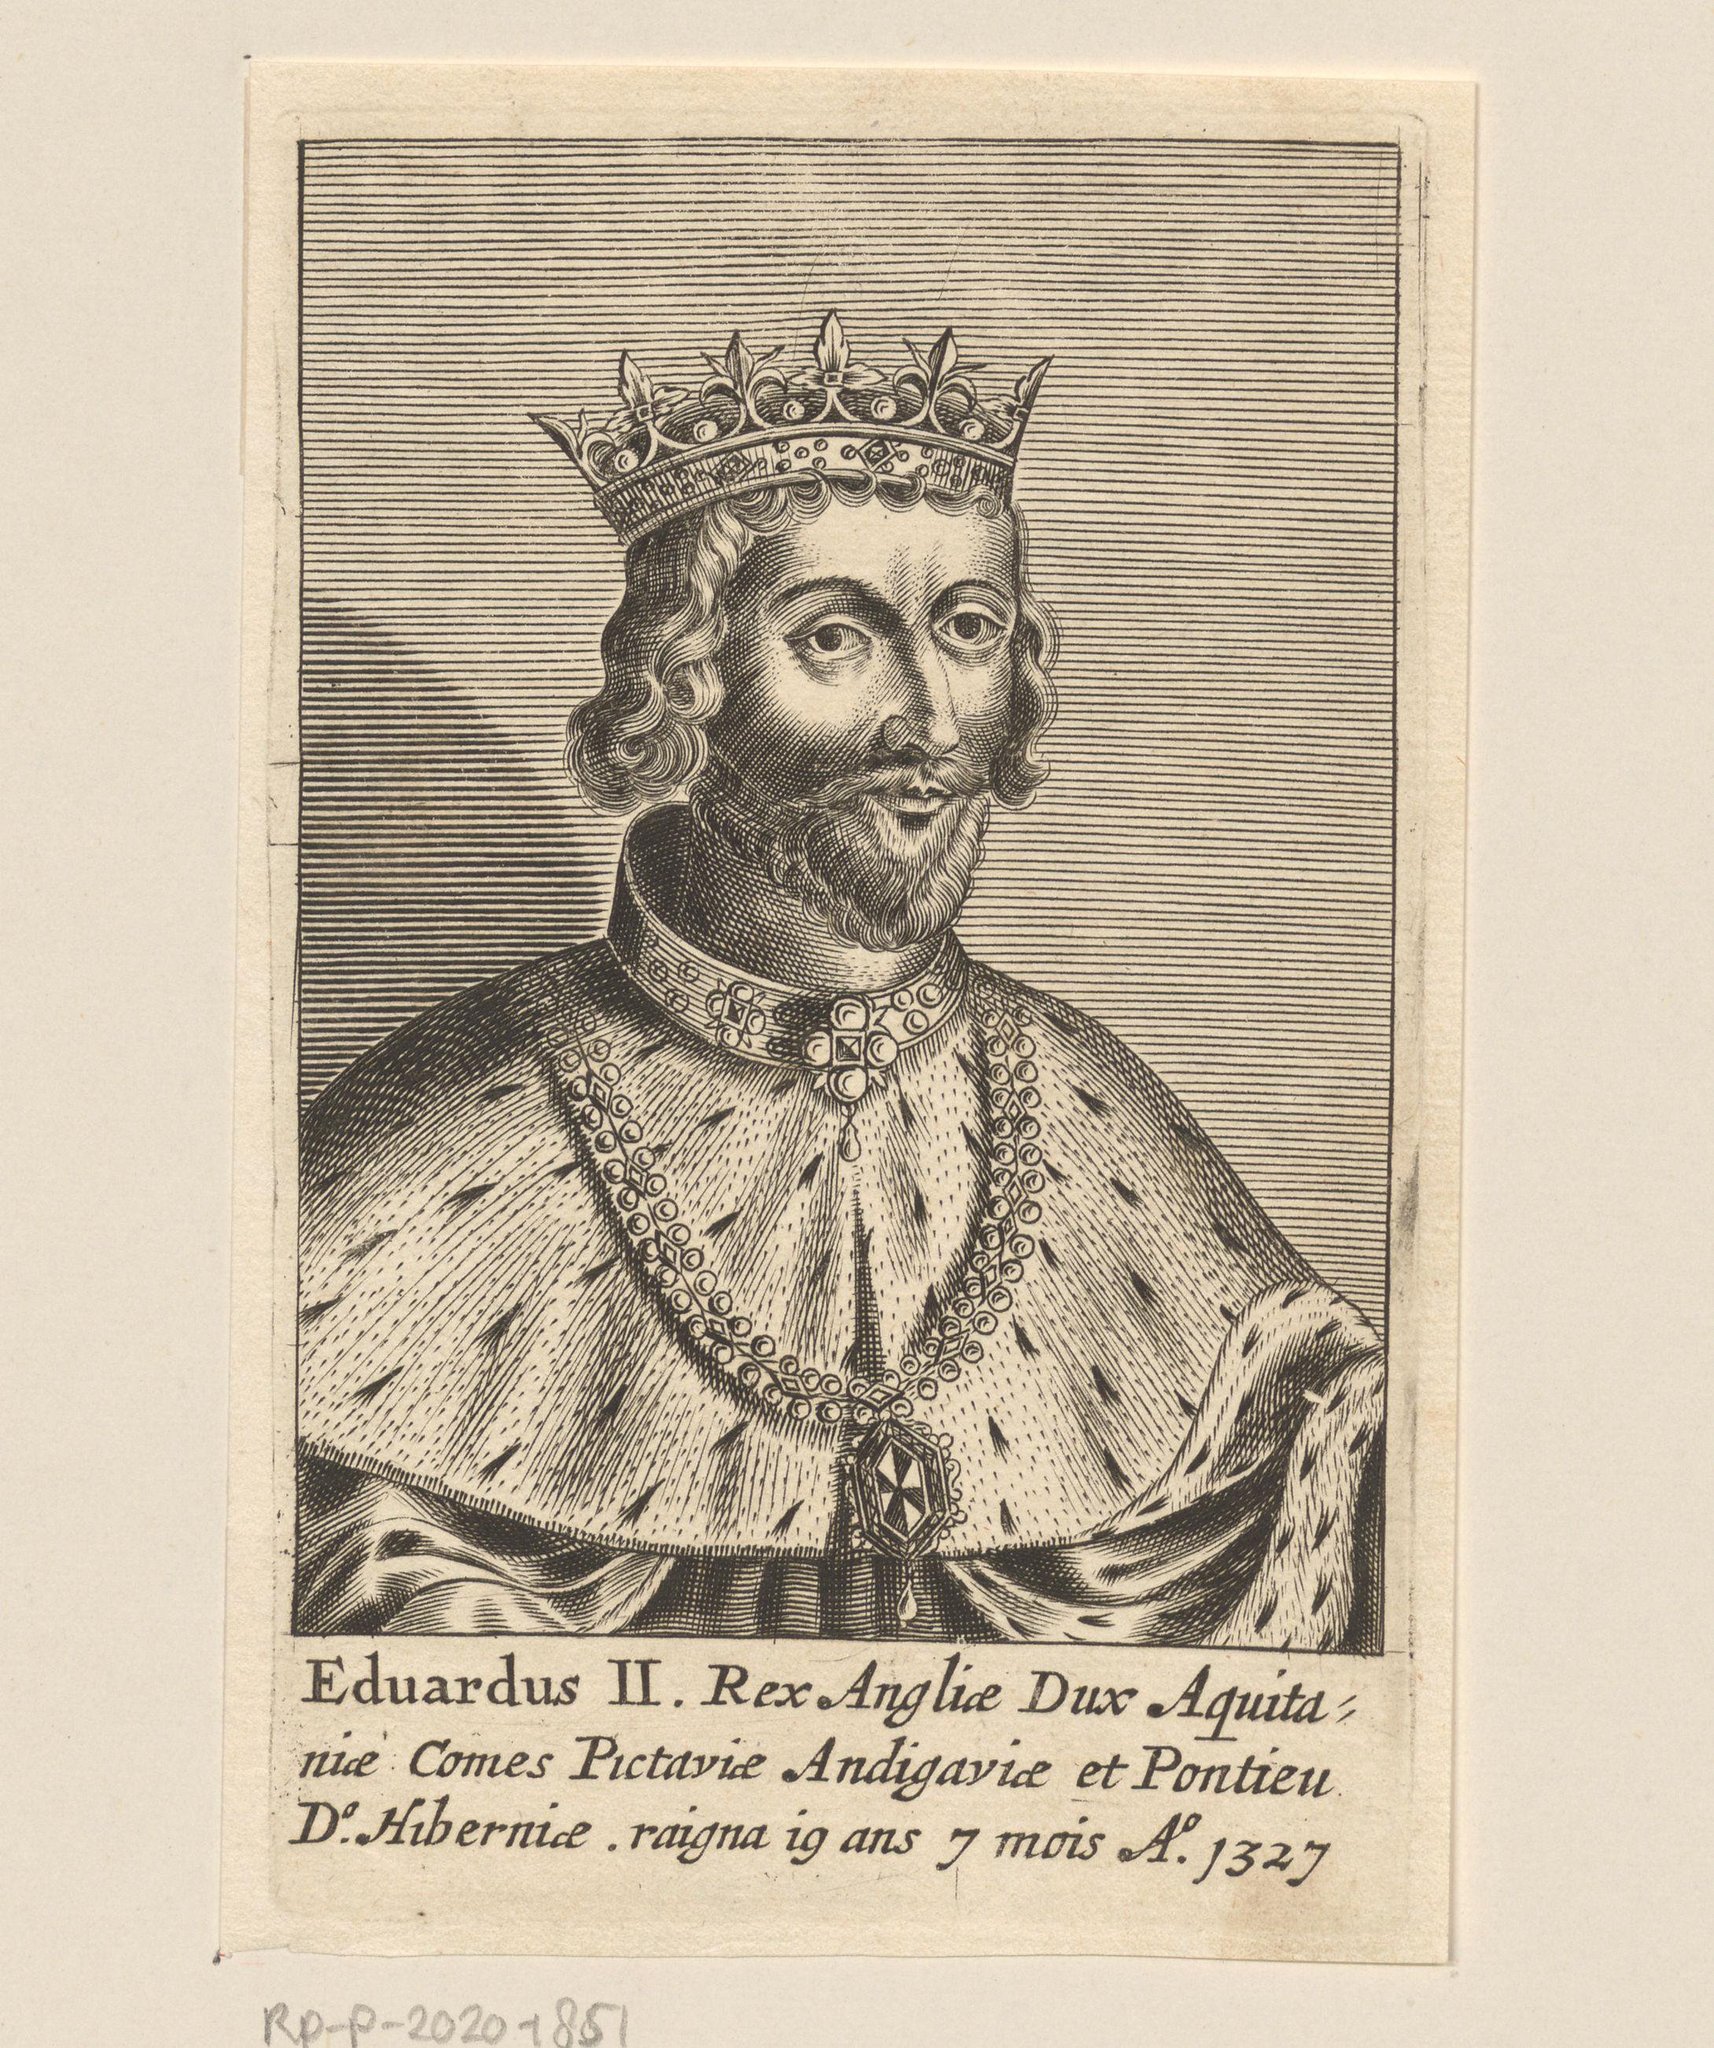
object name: print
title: Portret van Eduard II van Engeland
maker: Anonymous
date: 1649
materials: paper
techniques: engraving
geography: northern netherlands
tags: crown (symbol of sovereignty), historical persons, king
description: Prent met tekst op verso gebruikt in: Baker, Richard. Cronyke van het leven en bedryff van alle de coningen van Engeland (...). Amsterdam: Cornelis Dankertz., 1649, p. 176.